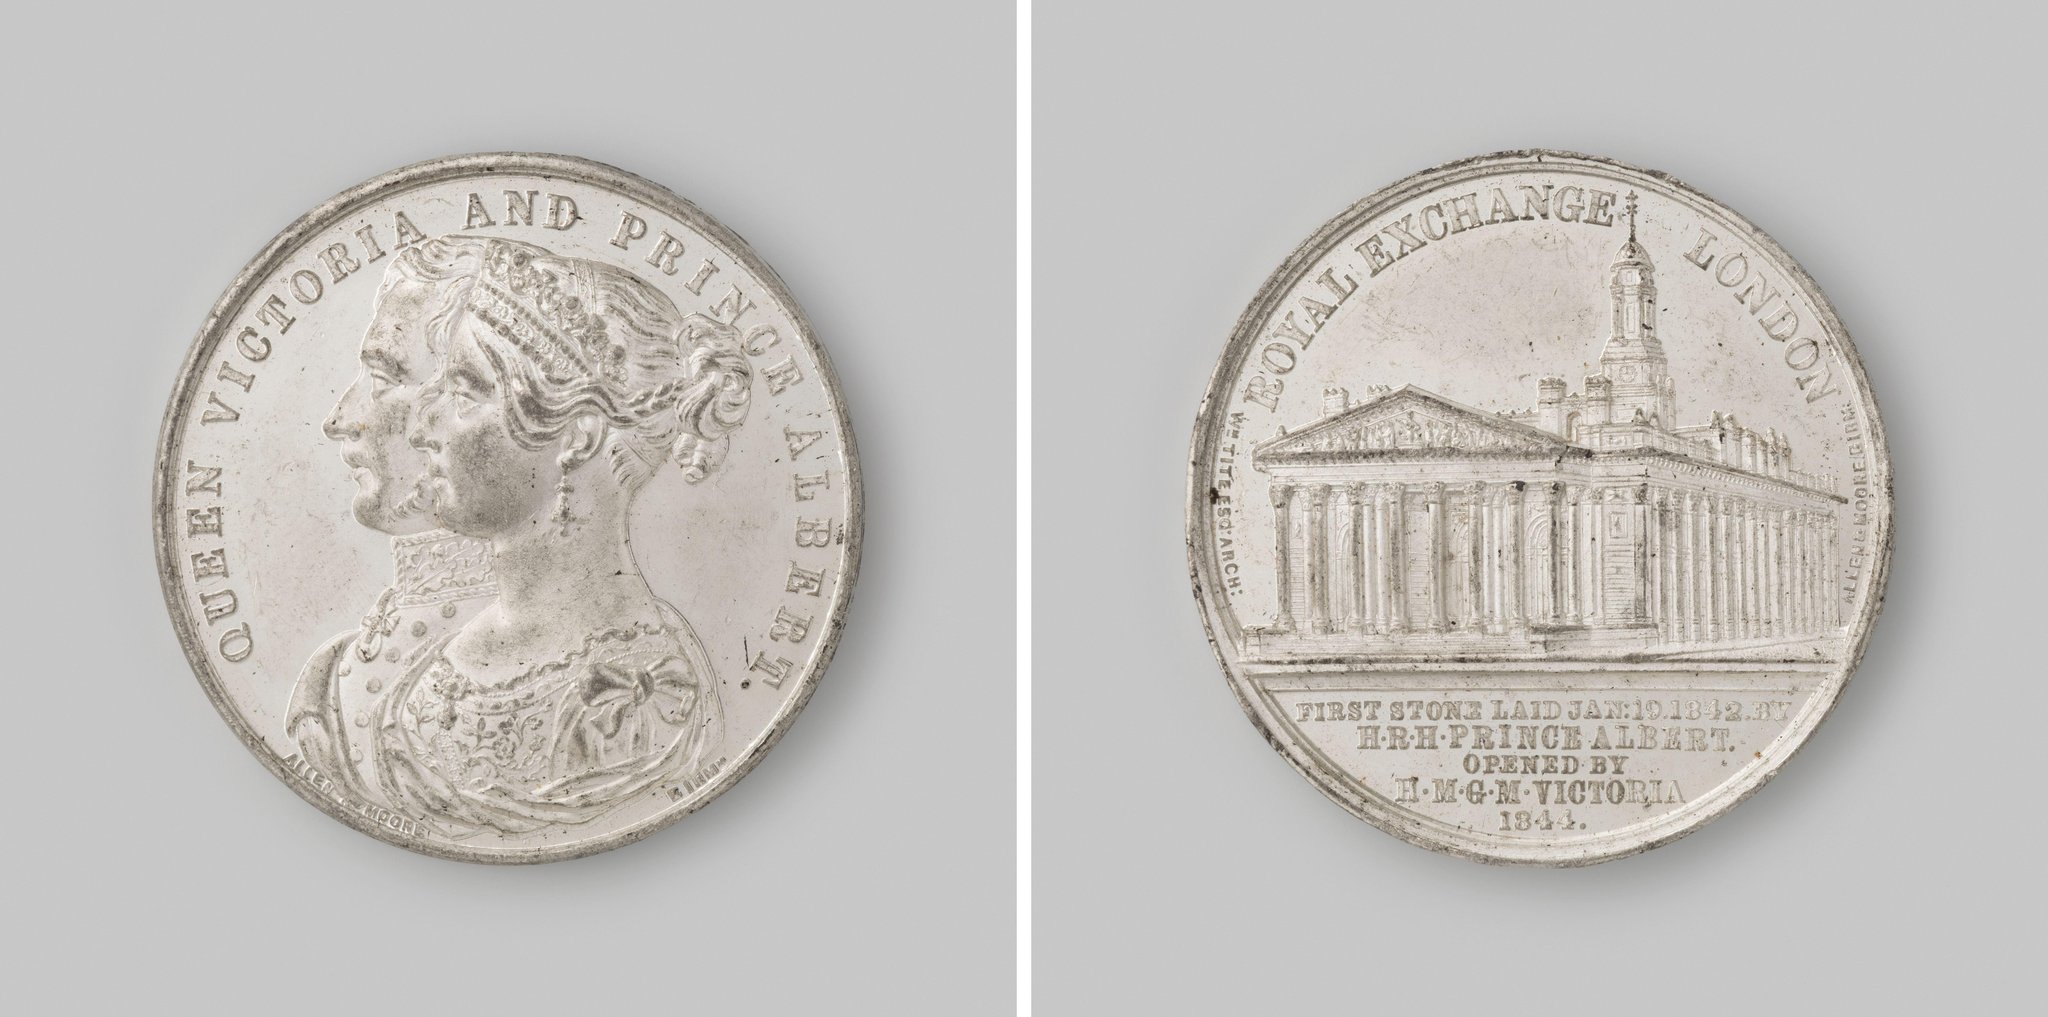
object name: history medal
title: Opening van de Beurs te Londen 1844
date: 1844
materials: tin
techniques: striking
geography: birmingham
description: Tinnen penning, op de voorzijde de geconjugeerde borstbeelden van Victoria en Albert met omschrift, op de keerzijde het beursgebouw met omschrift en vijf regels afsnedetekst.